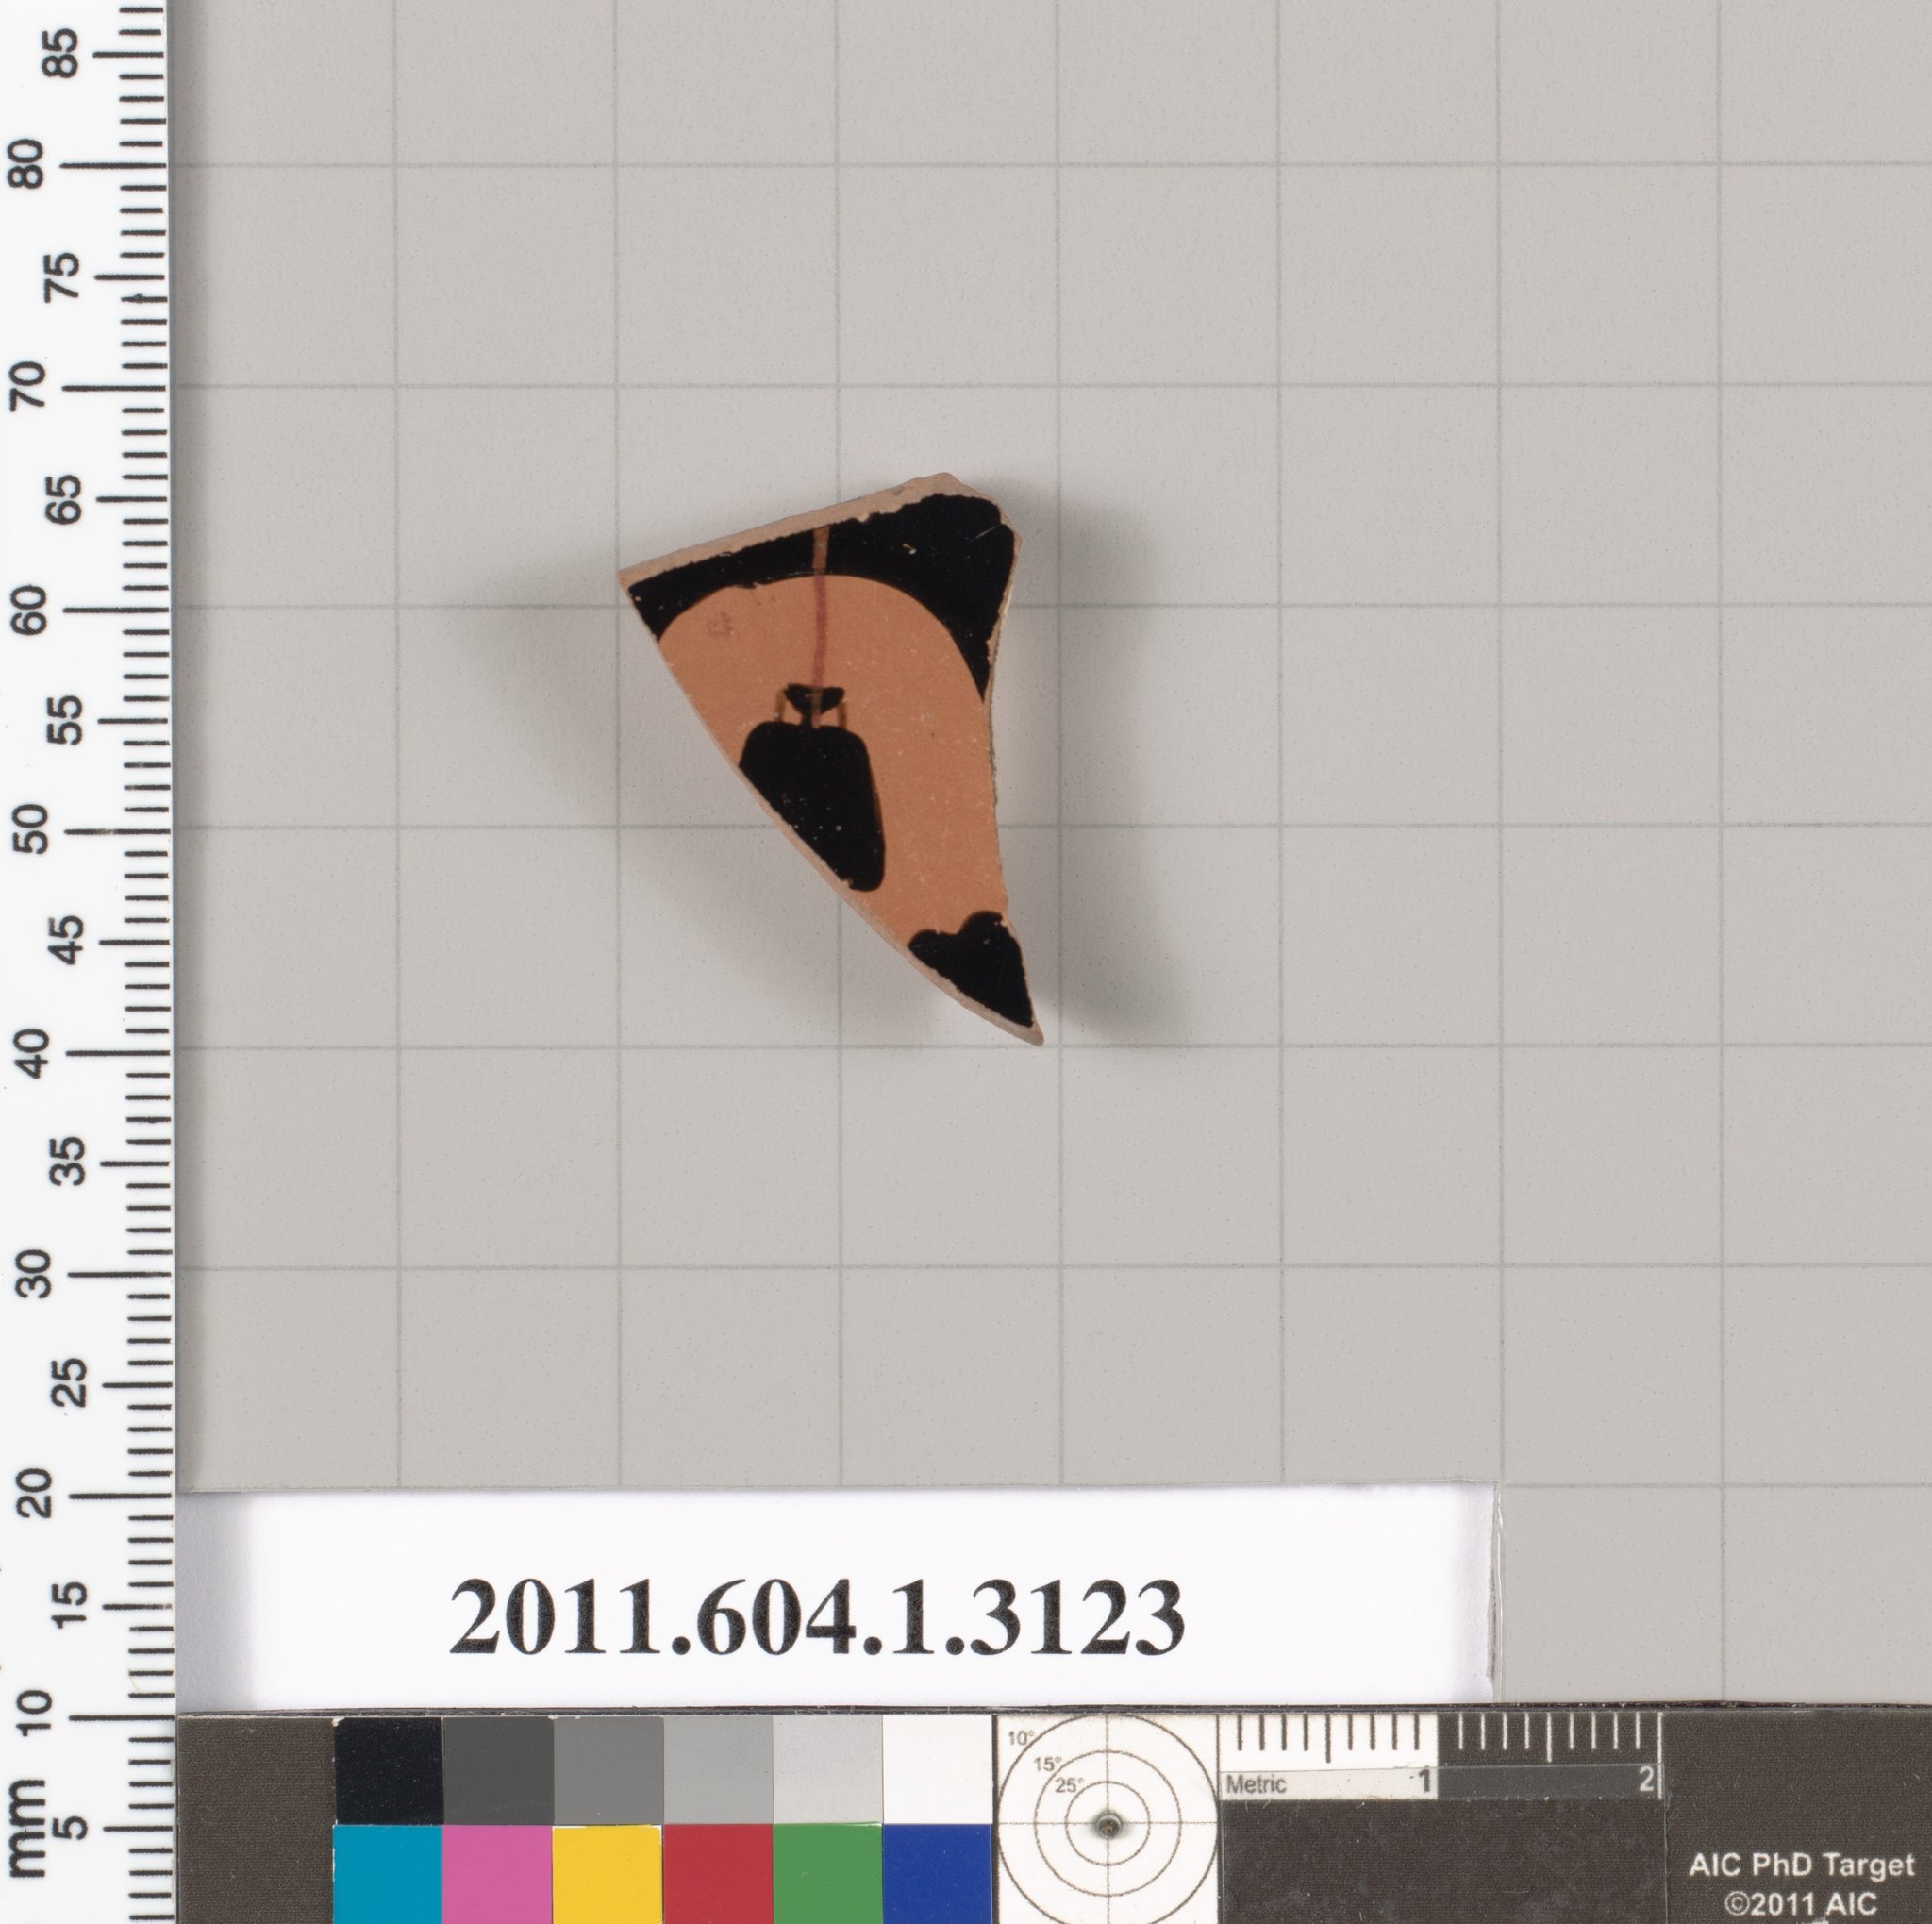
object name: kylix fragment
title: Terracotta fragment of a kylix (drinking cup)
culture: greek, attic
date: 510-480 BCE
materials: terracotta